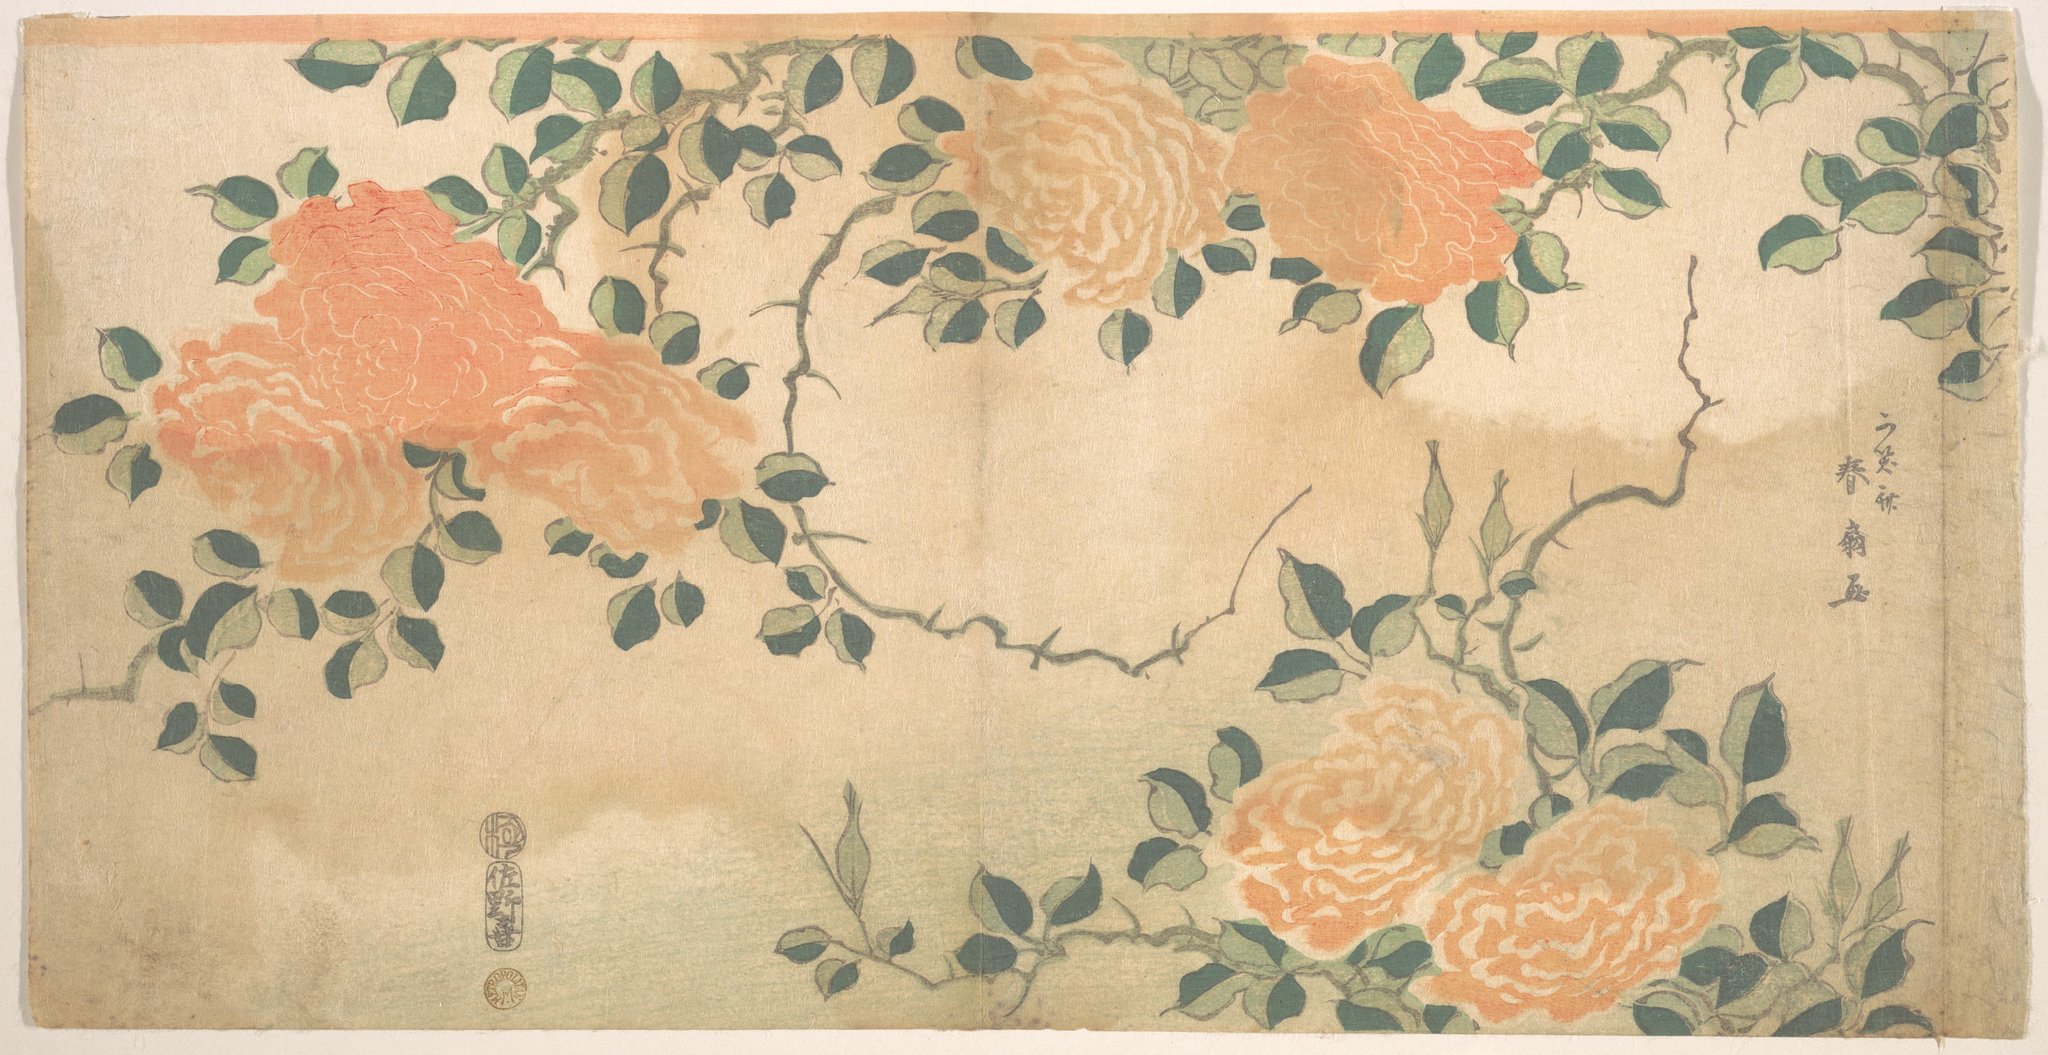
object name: print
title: Roses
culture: japanese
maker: kashosai shunsen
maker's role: artist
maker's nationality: japanese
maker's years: 1830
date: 1810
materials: ink, paper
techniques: woodblock print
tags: roses,leaves